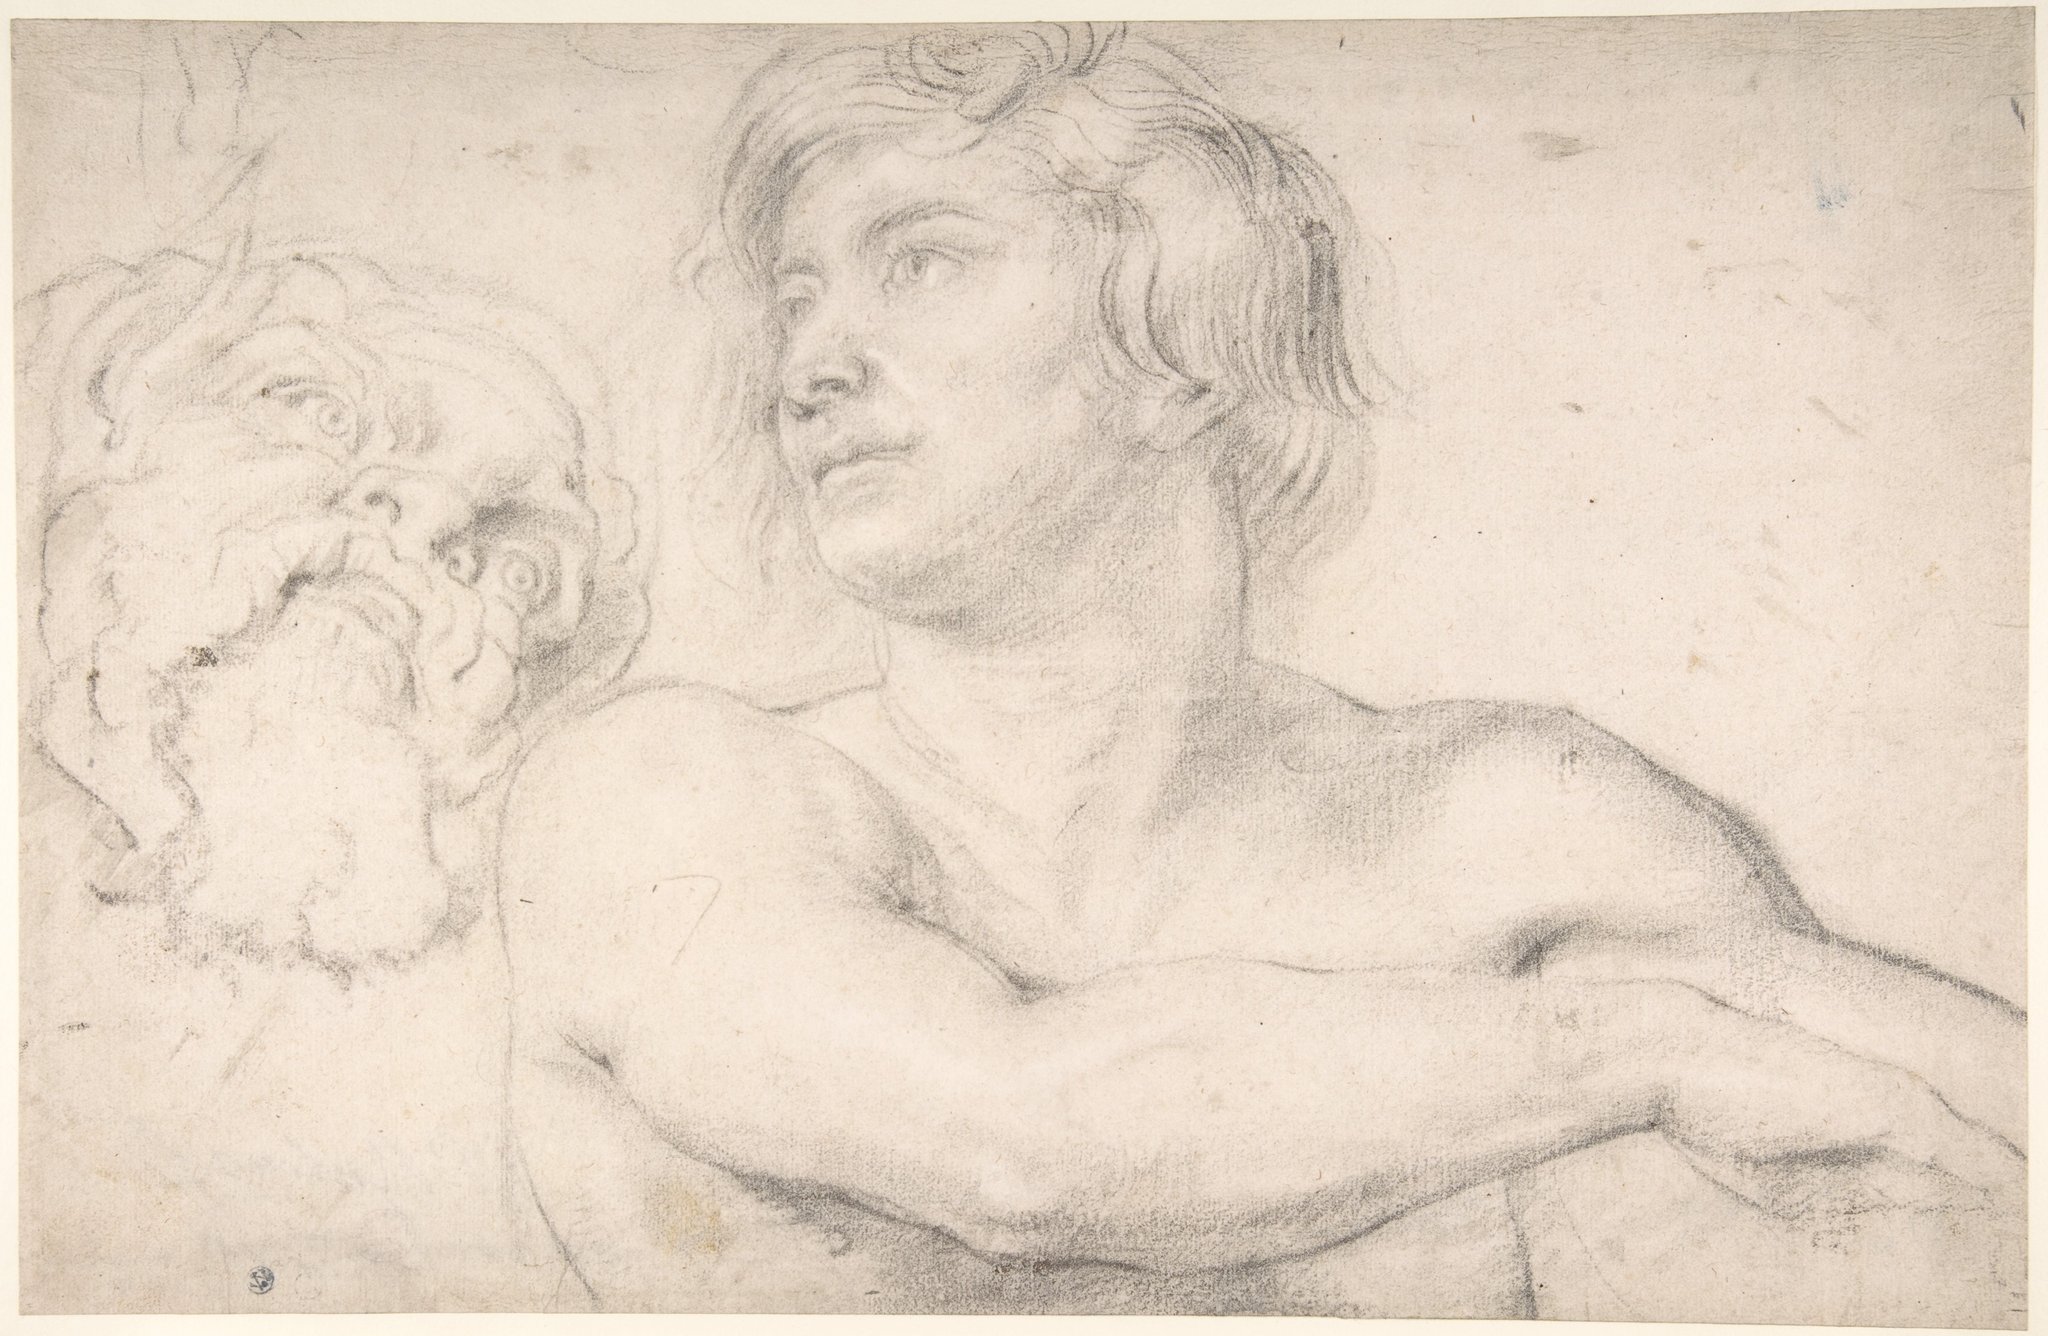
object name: drawing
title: Half-Figure of a Nude Man Facing Left, Head of a Satyr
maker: peter paul rubens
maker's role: artist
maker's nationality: flemish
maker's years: 1577-1640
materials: chalk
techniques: heightening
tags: men,satyrs